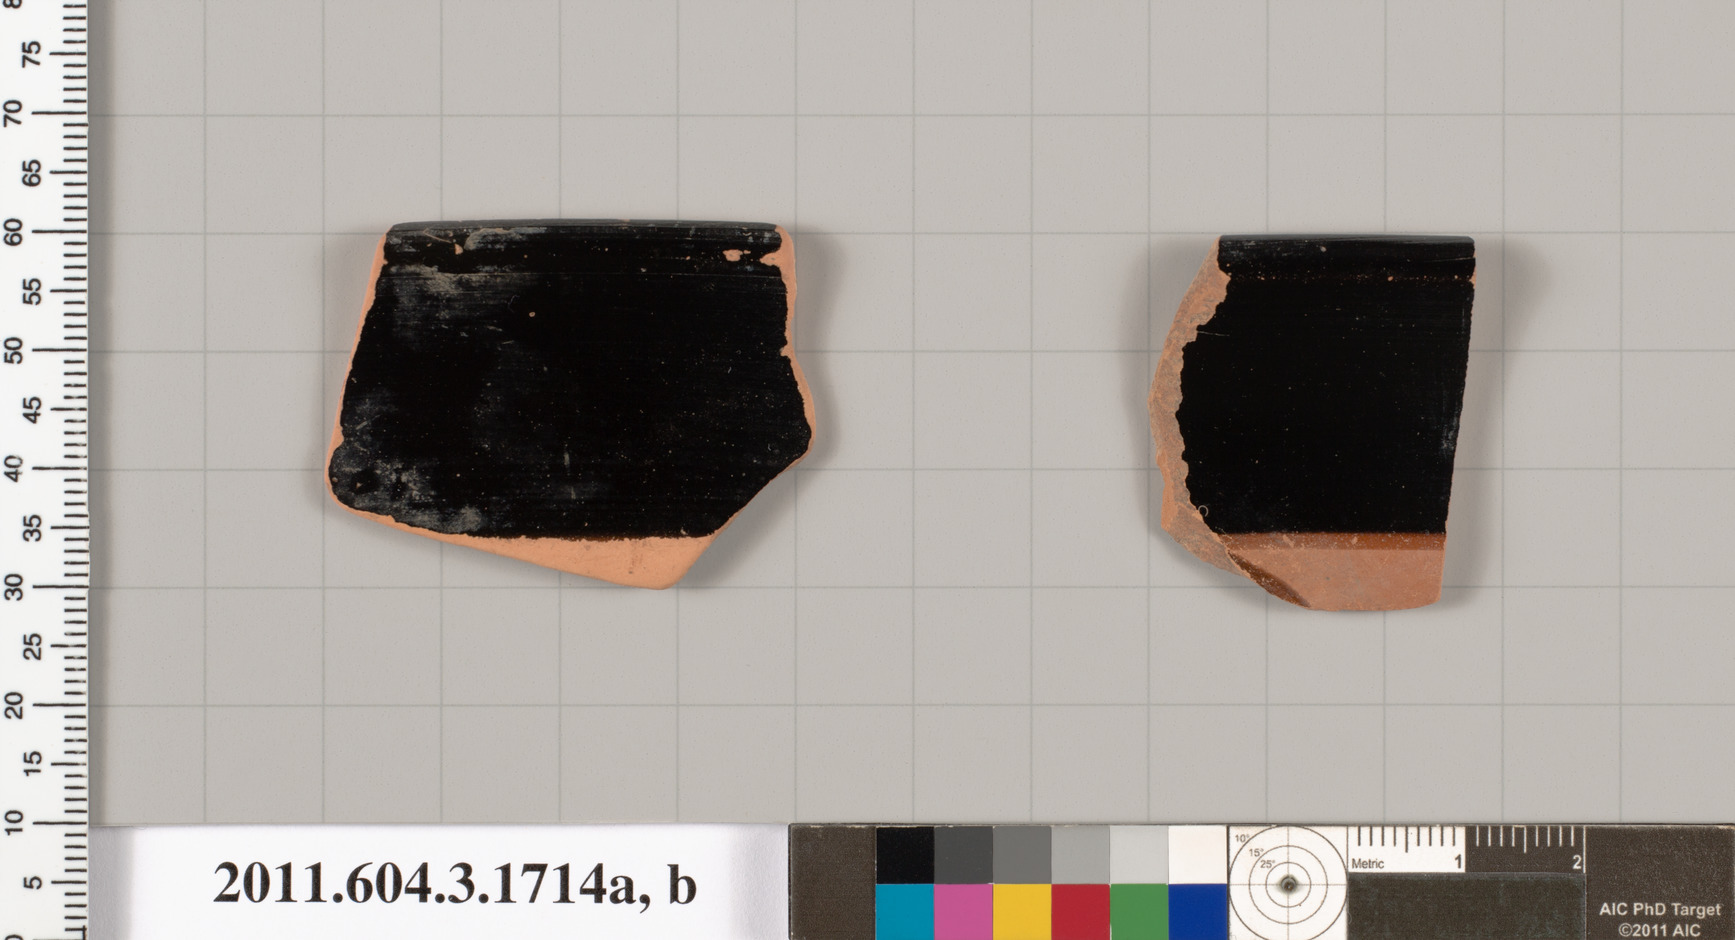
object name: kylix fragment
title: Terracotta rim fragments of kylikes: Band cups (drinking cups)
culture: greek, attic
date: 550-526 BCE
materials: terracotta